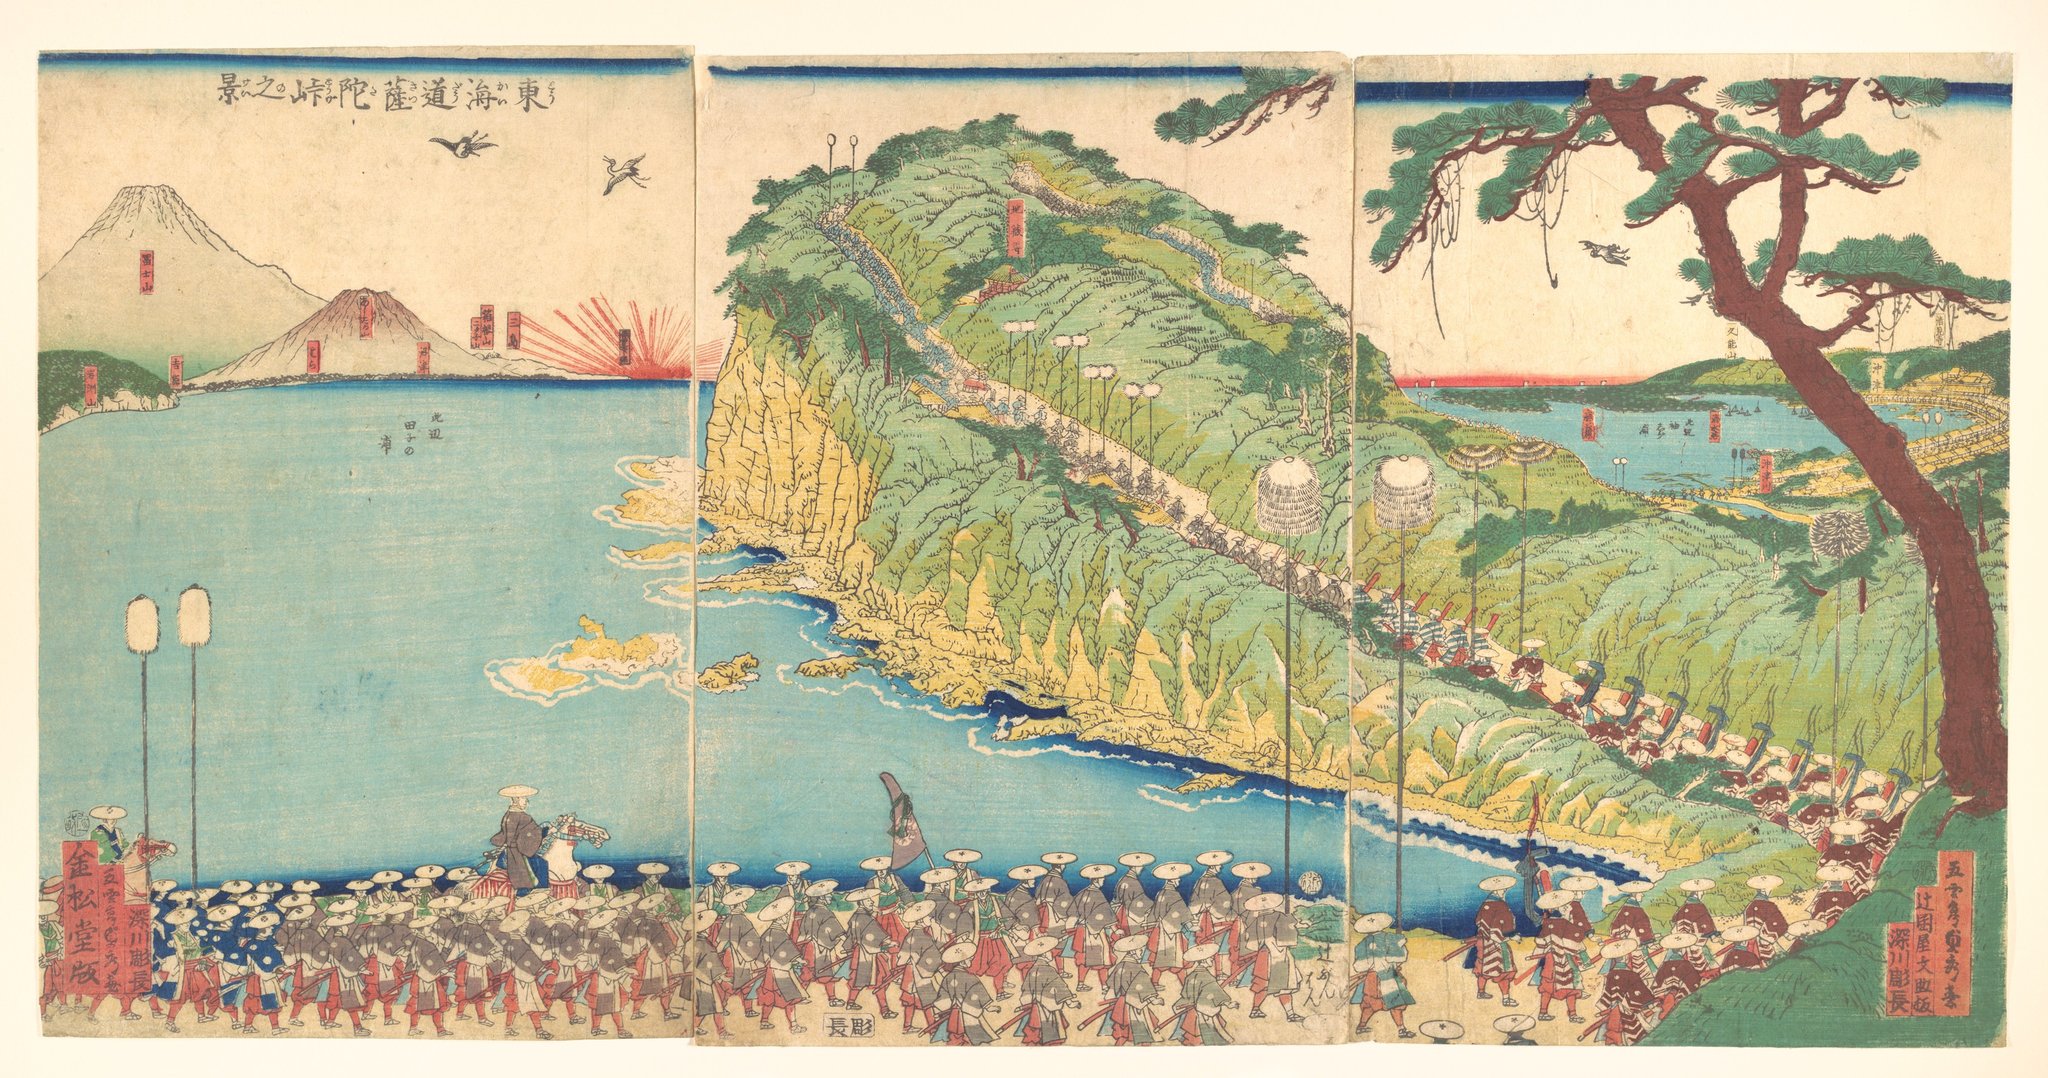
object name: print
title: Daimyo's Processions Passing along the Tōkaidō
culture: japanese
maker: utagawa (gountei) sadahide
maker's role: artist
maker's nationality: japanese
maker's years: 1807-1873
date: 1801-1900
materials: ink, paper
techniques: woodblock print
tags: hills,processions